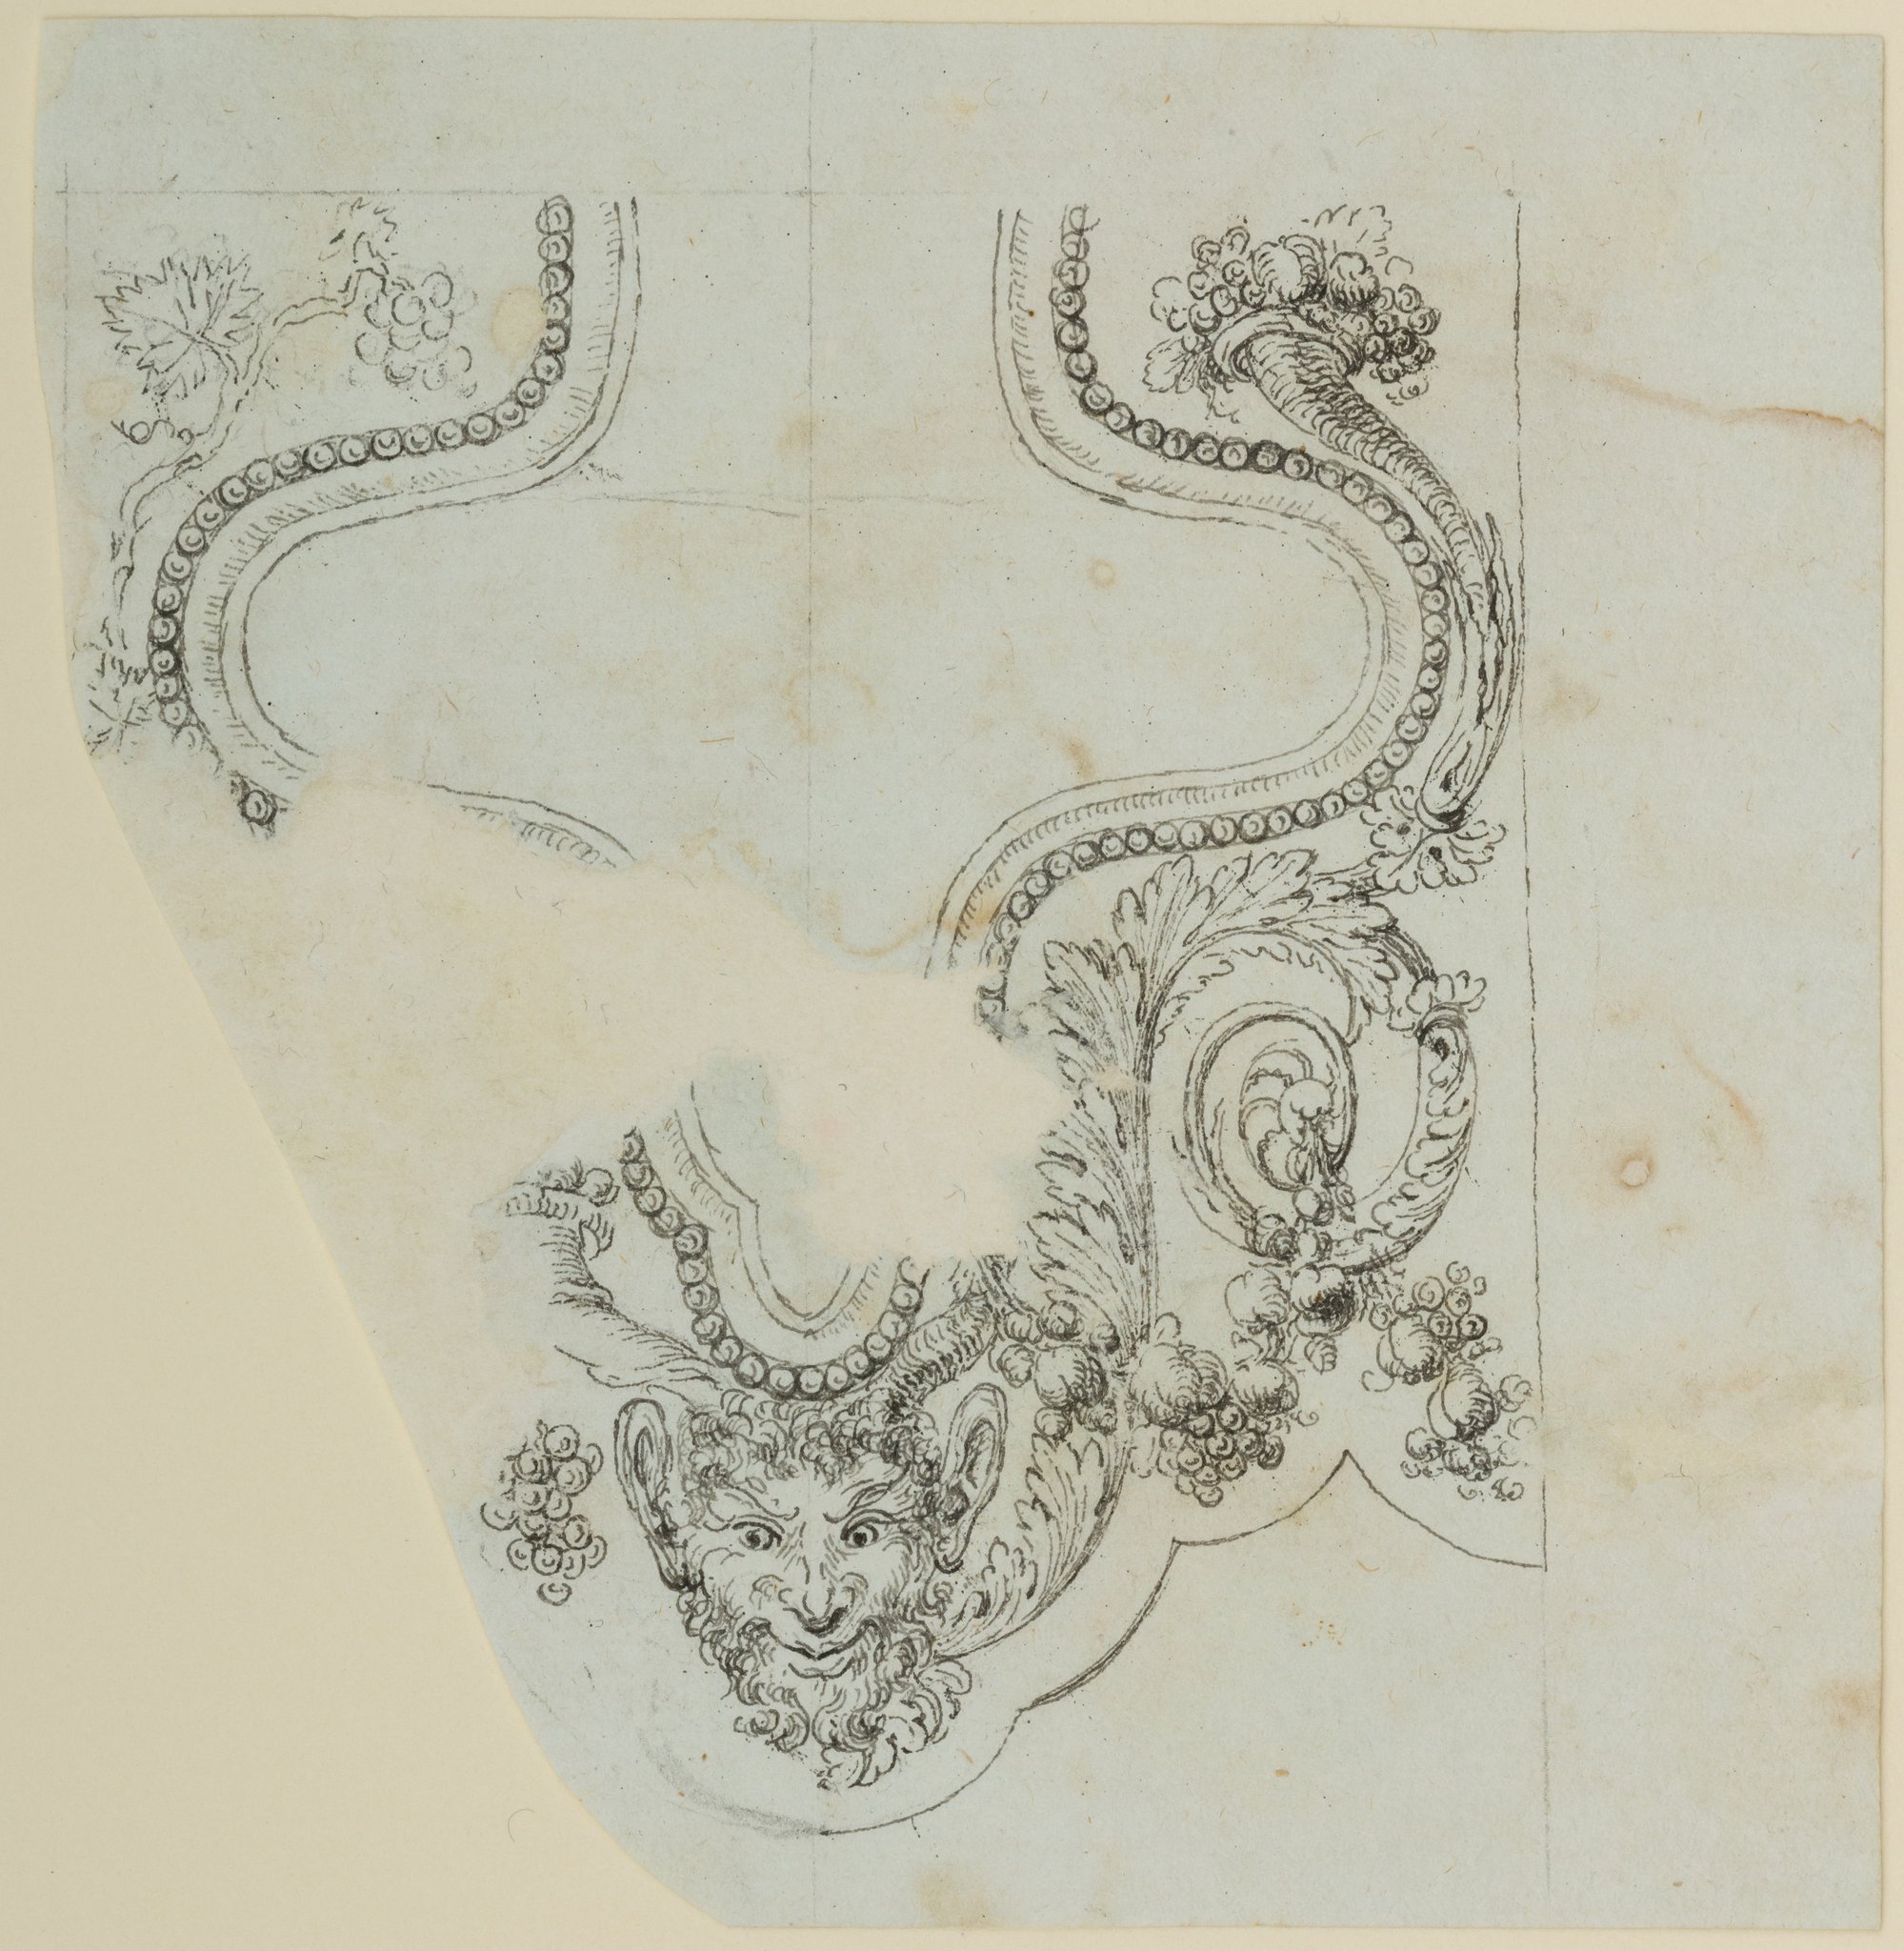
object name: drawing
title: Design for the Decoration of the Surround of the Rear Sight of a Firearm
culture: french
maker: nicolas noël boutet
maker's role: designer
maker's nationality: french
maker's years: 1761-1833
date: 1797-1805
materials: ink, paper, pencil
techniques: wash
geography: france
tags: fruit,satyrs